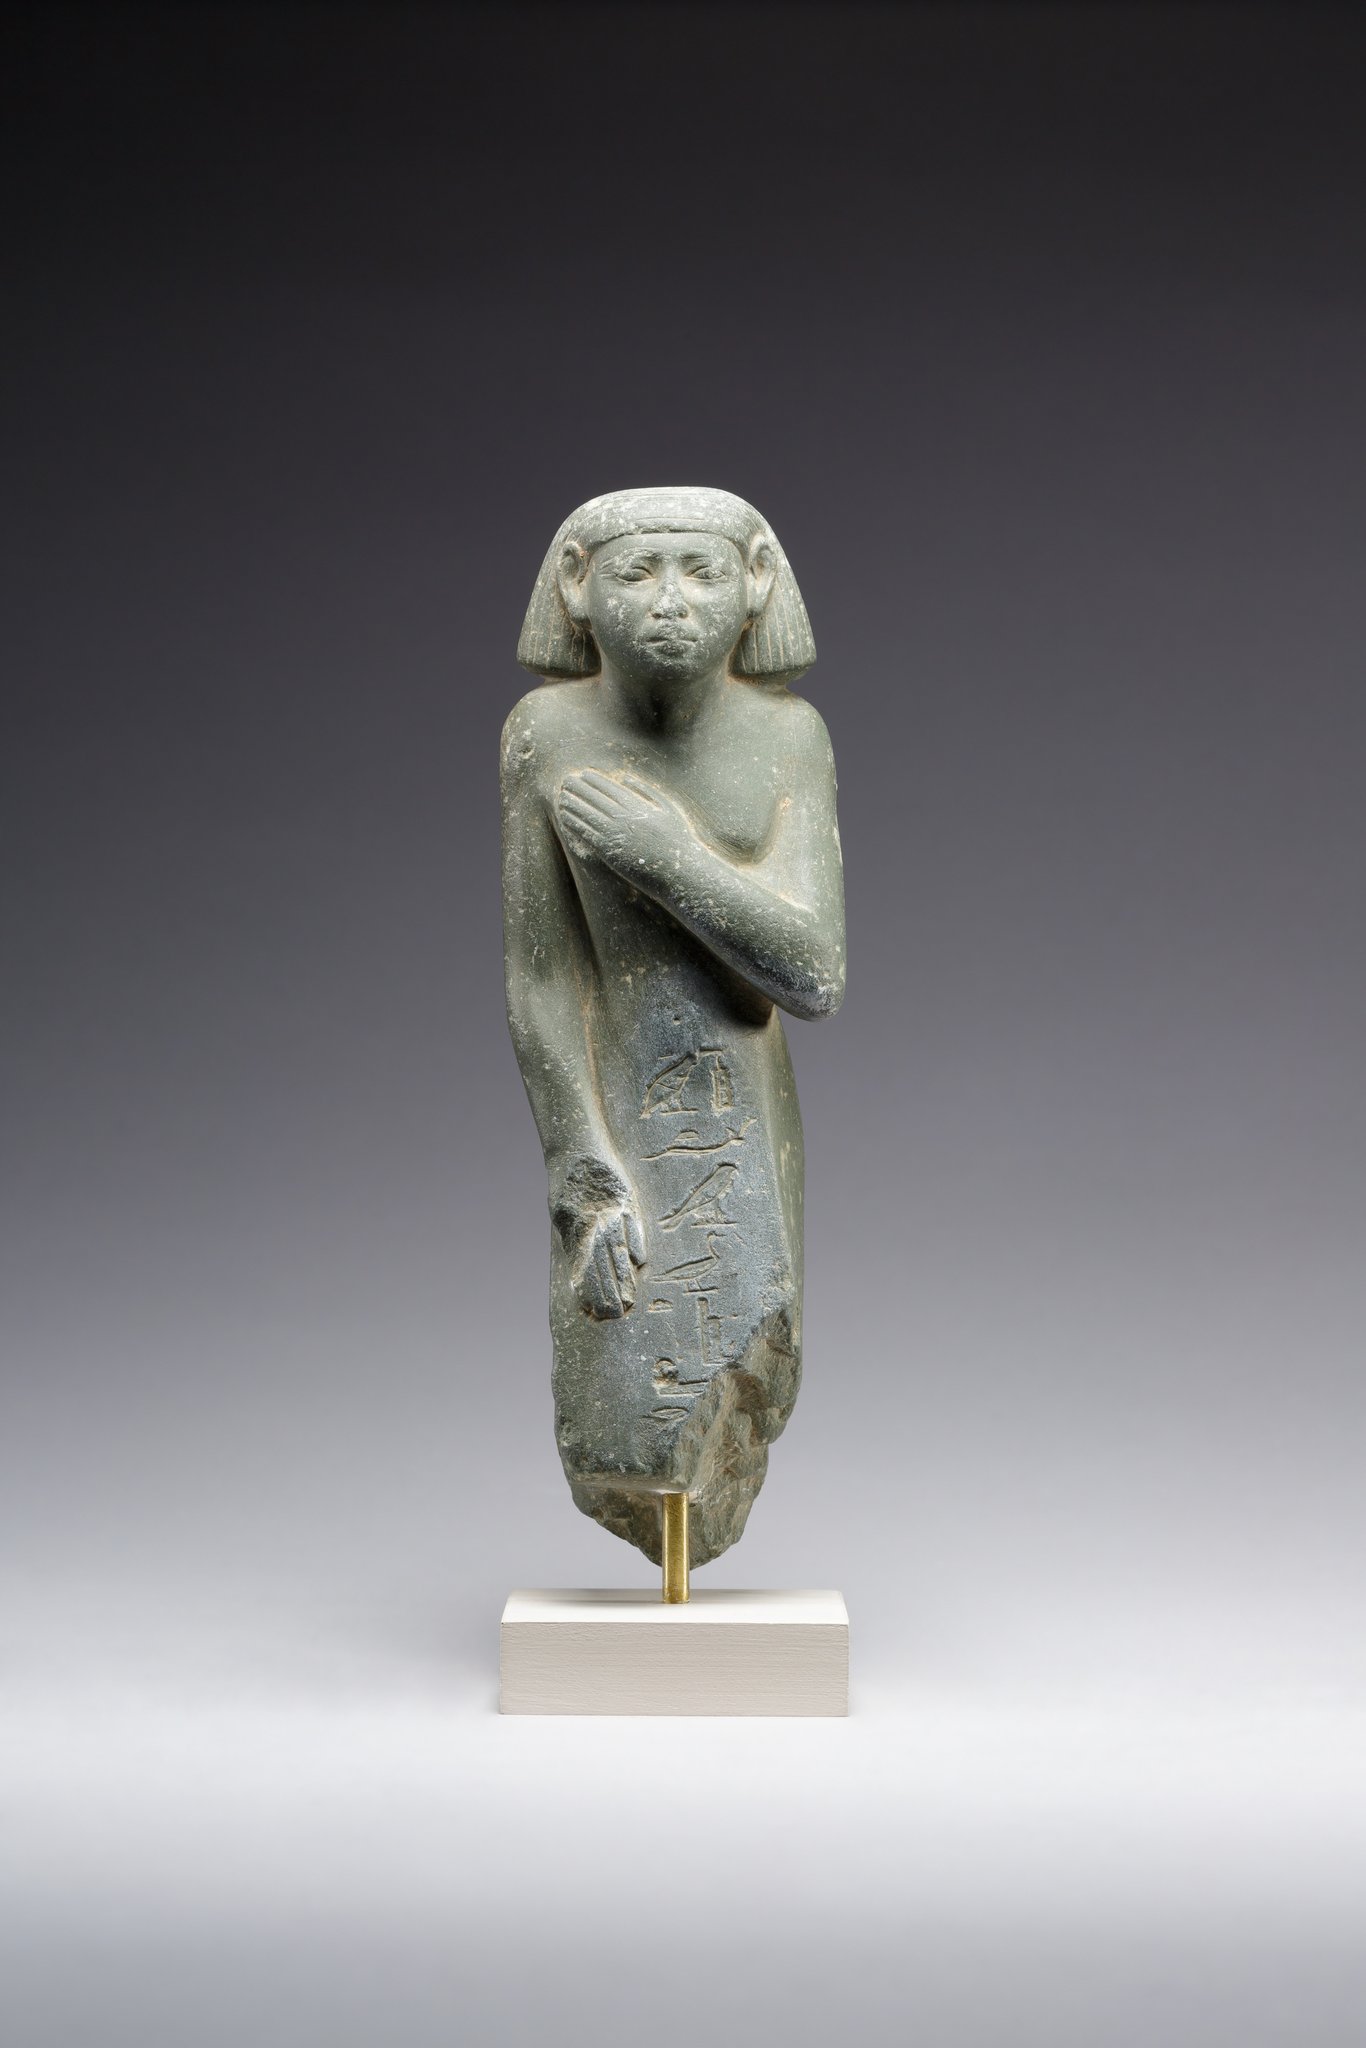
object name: statuette, man, reinscribed for harsiese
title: Middle Kingdom statuette, reinscribed for Harsiese High Priest of Memphis in the Third Intermediate Period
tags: men,hieroglyphs